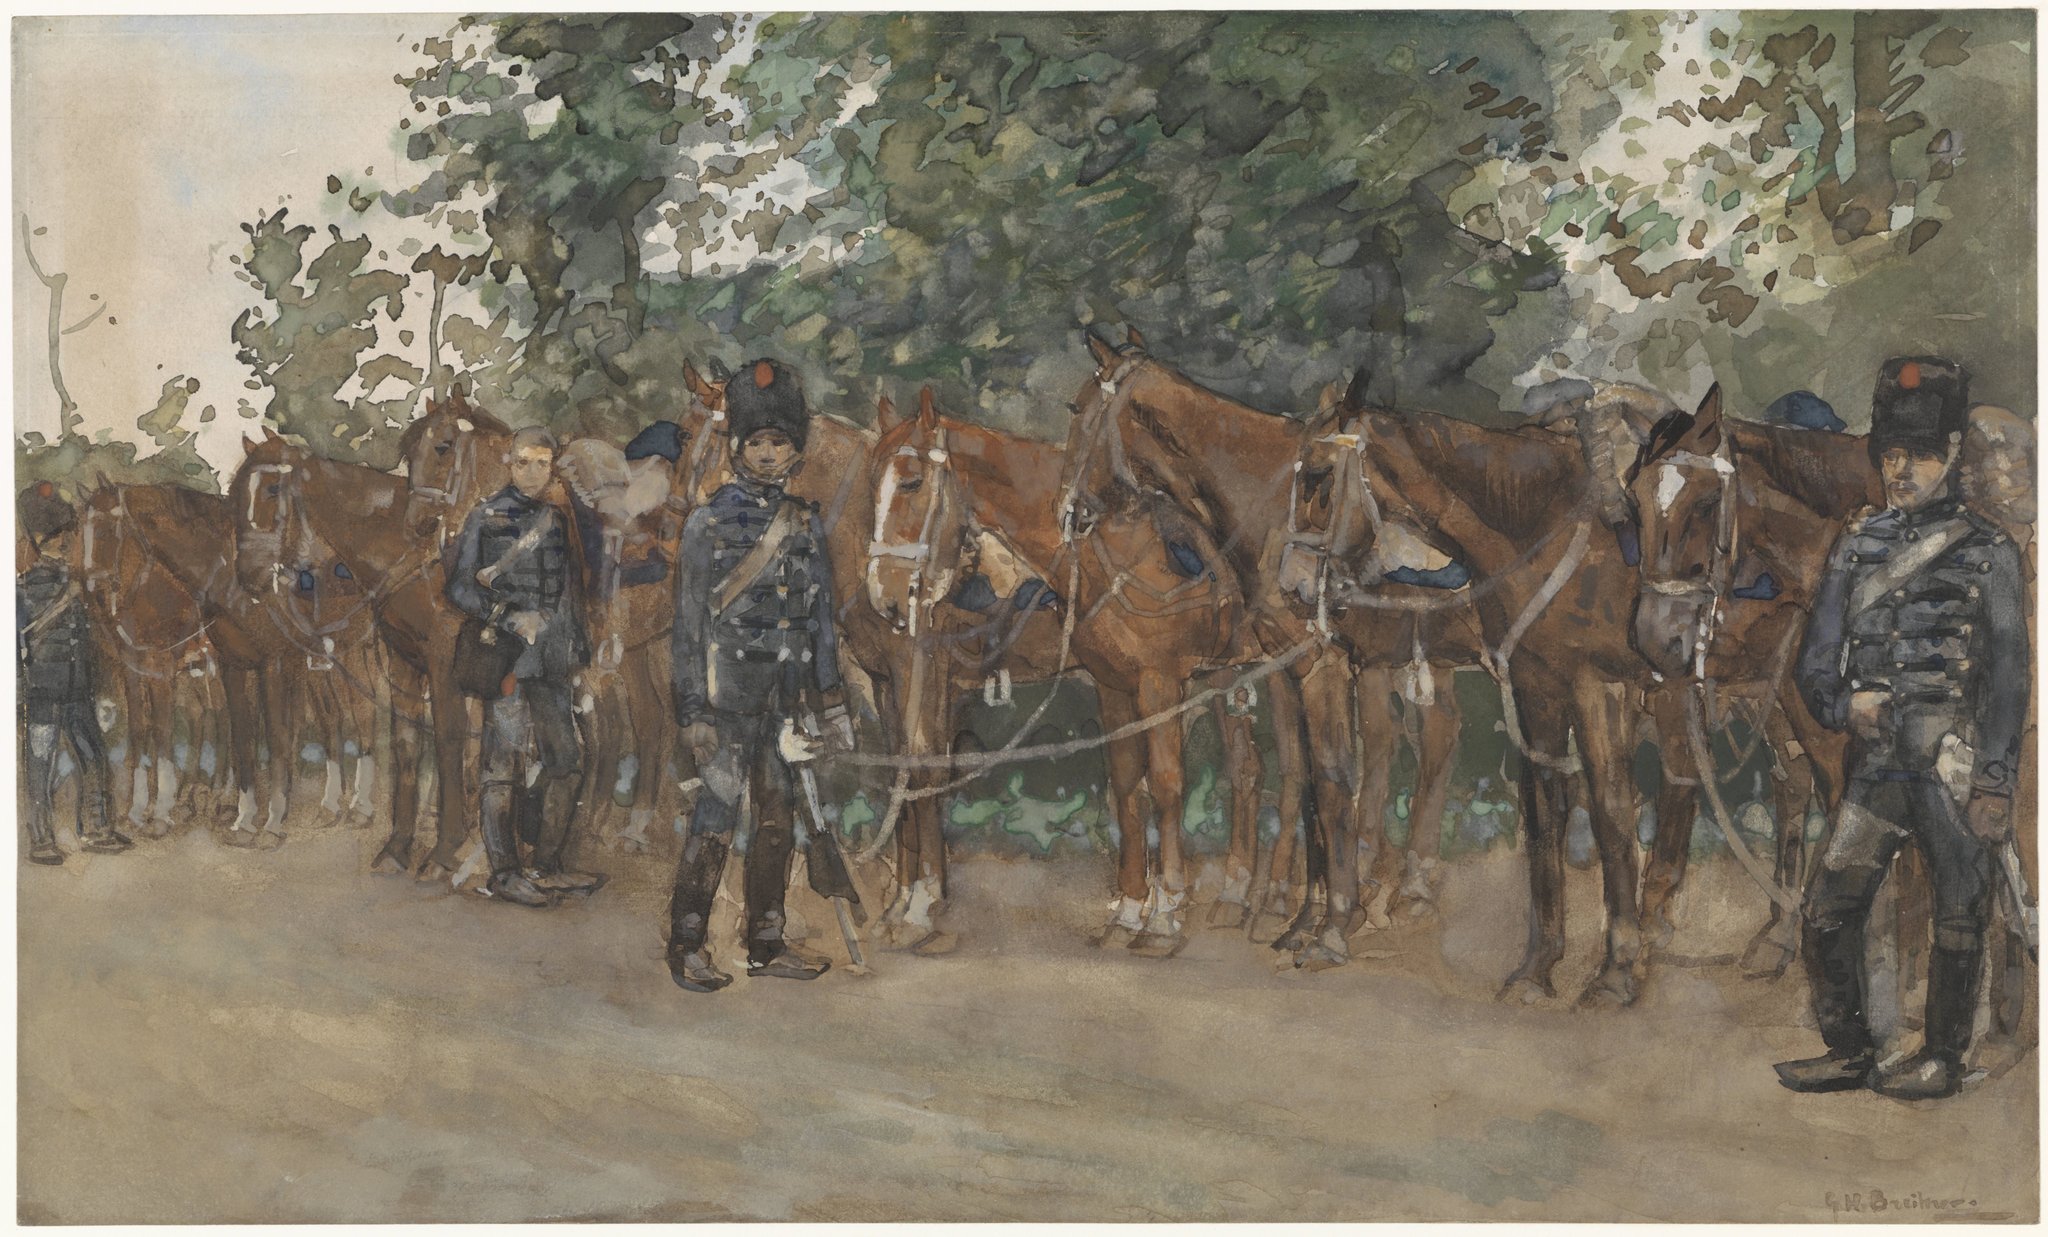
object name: drawing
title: Huzaren staande naast hun paarden langs de kant van de weg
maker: george hendrik breitner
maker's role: draughtsman, painter, print maker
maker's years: 1857-1923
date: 1867-1923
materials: paint, paper, pencil, watercolor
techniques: brush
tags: private soldier (+ cavalry, horsemen)